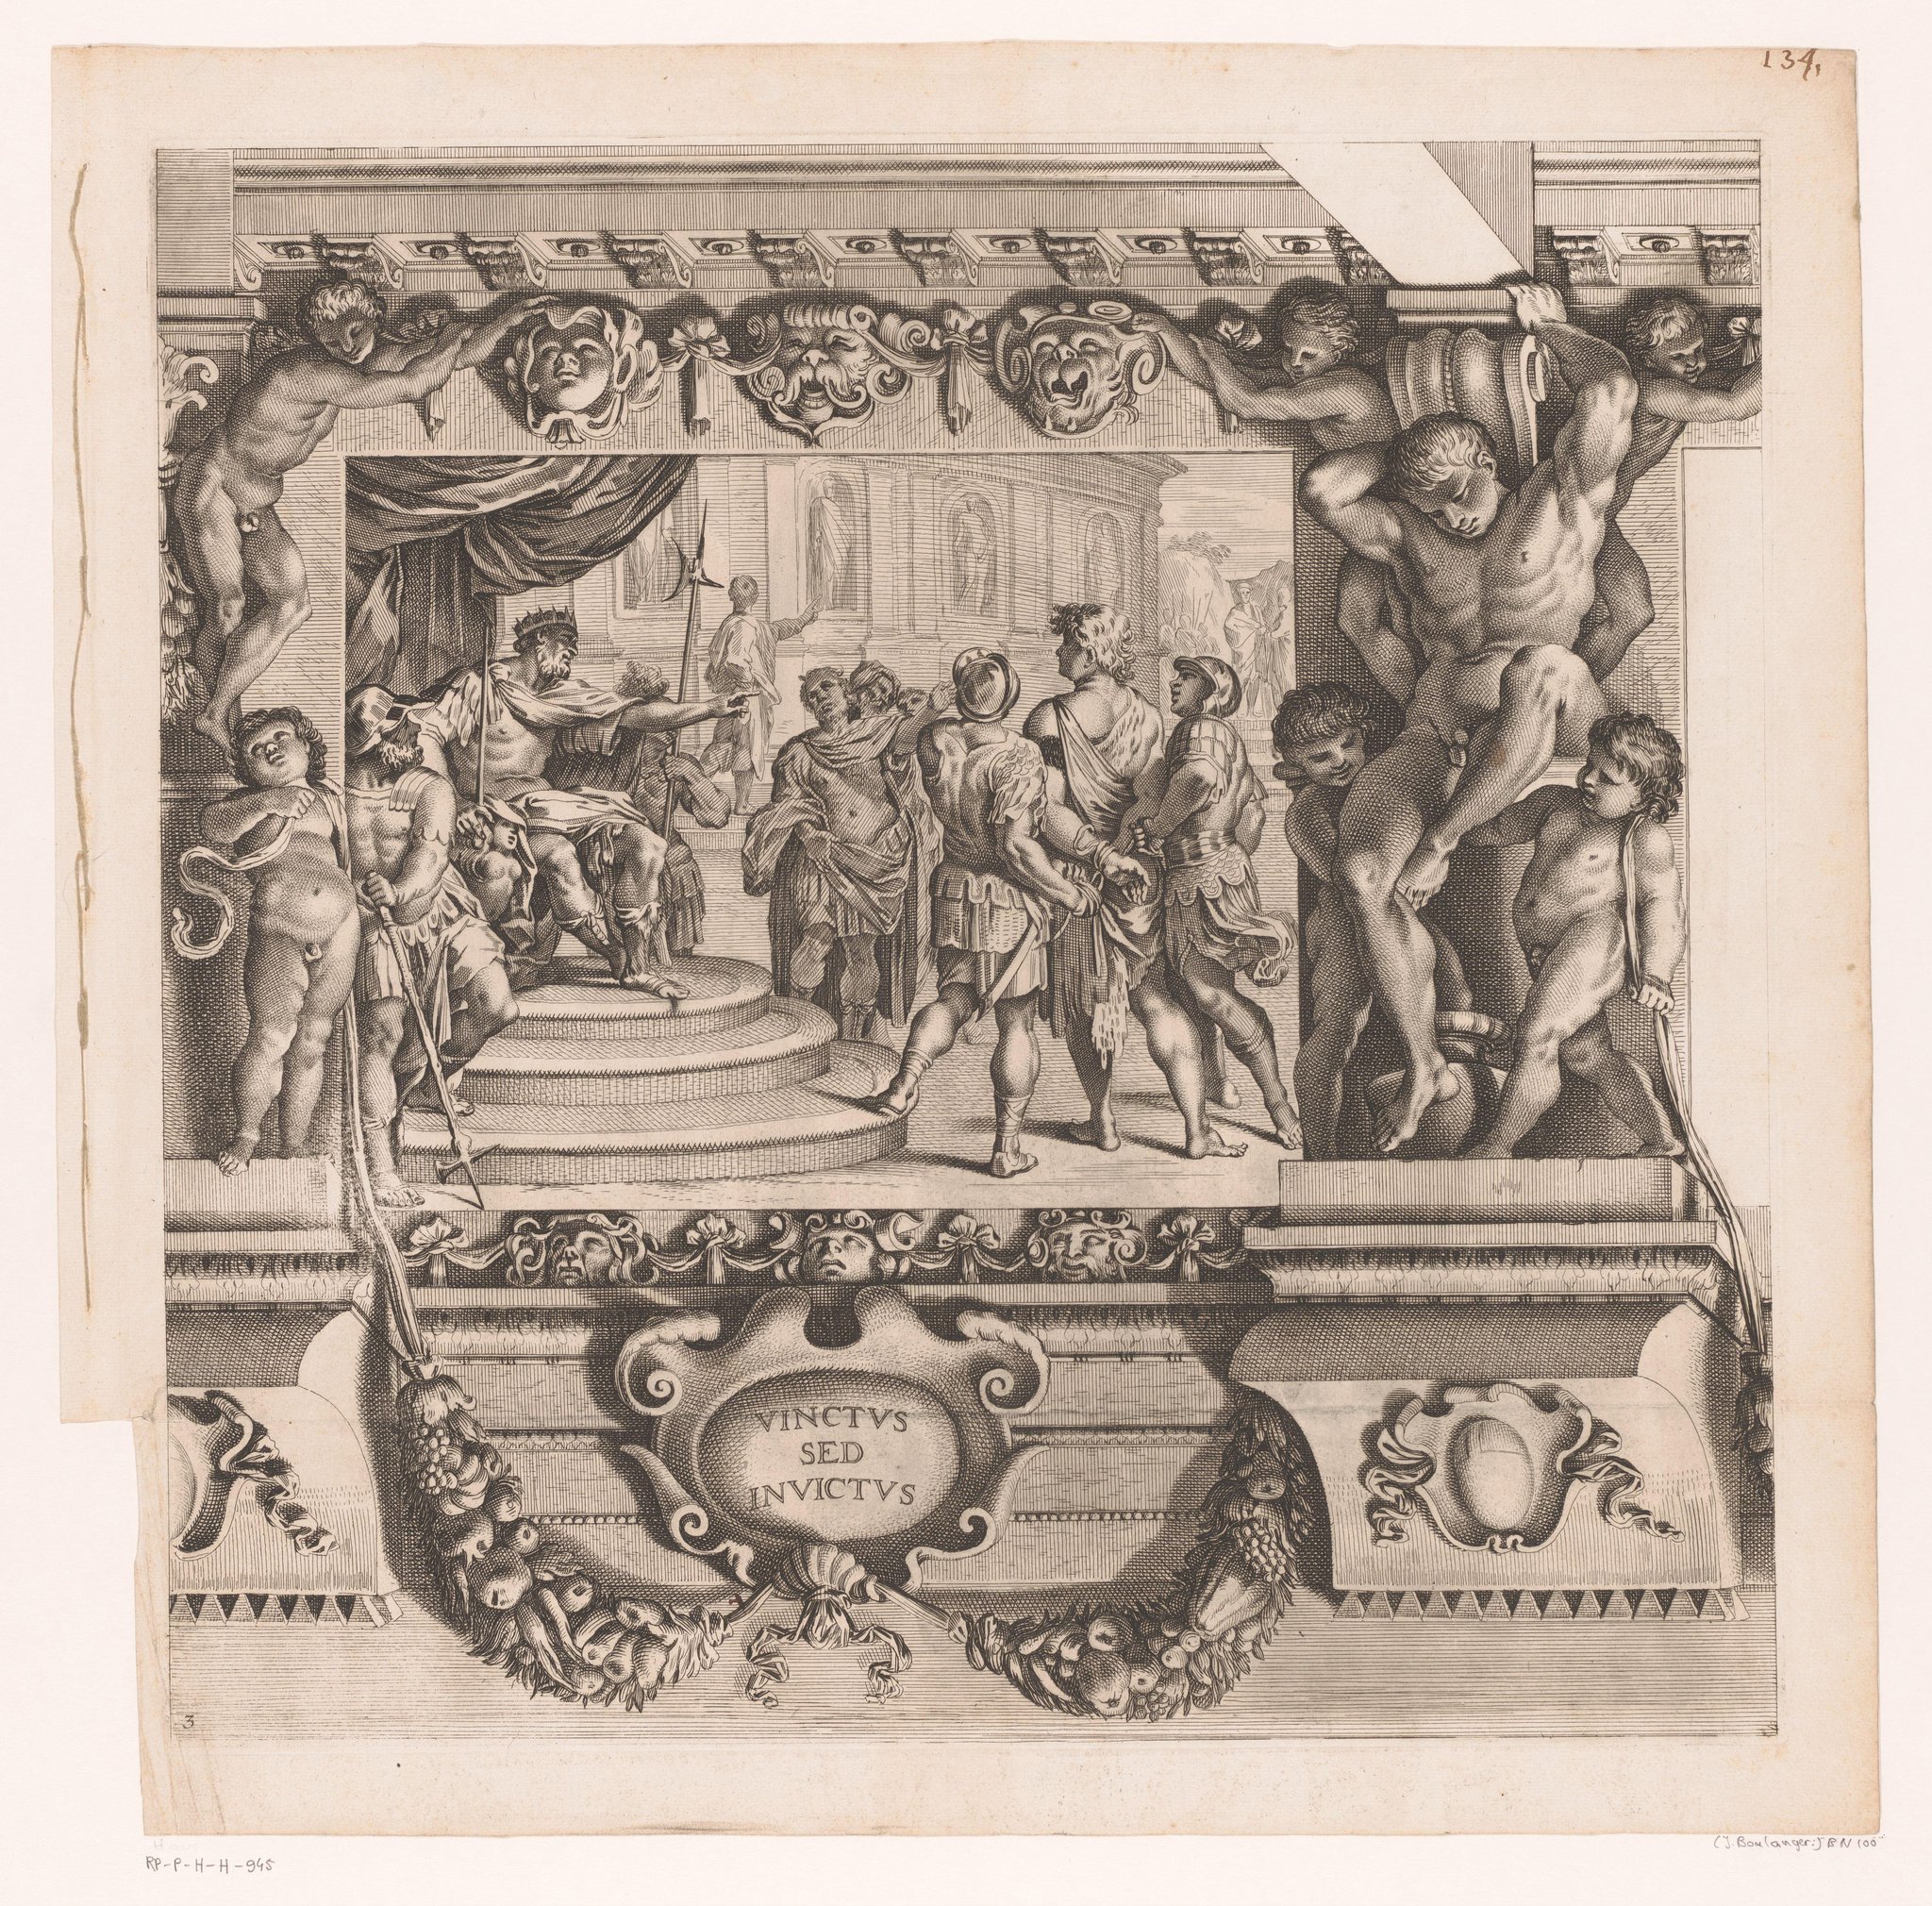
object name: print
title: Remus voor koning Amulius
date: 1659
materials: paper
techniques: engraving, etching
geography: bologna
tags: remus is captured during the festival of the lupercalia and brought before amulius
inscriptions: number: ‘134.’, collector's mark: Lugt 11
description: Maakt deel uit van een 14-delige serie met scènes uit het verhaal van Romulus en Remus naar ontwerpen door de familie Carracci voor het Palazzo Magnani te Bologna. Prent 1 t/m 7 zijn in prent gebracht door Lepautre en Boulanger en prent 8 t/m 14 door De Châtillon.